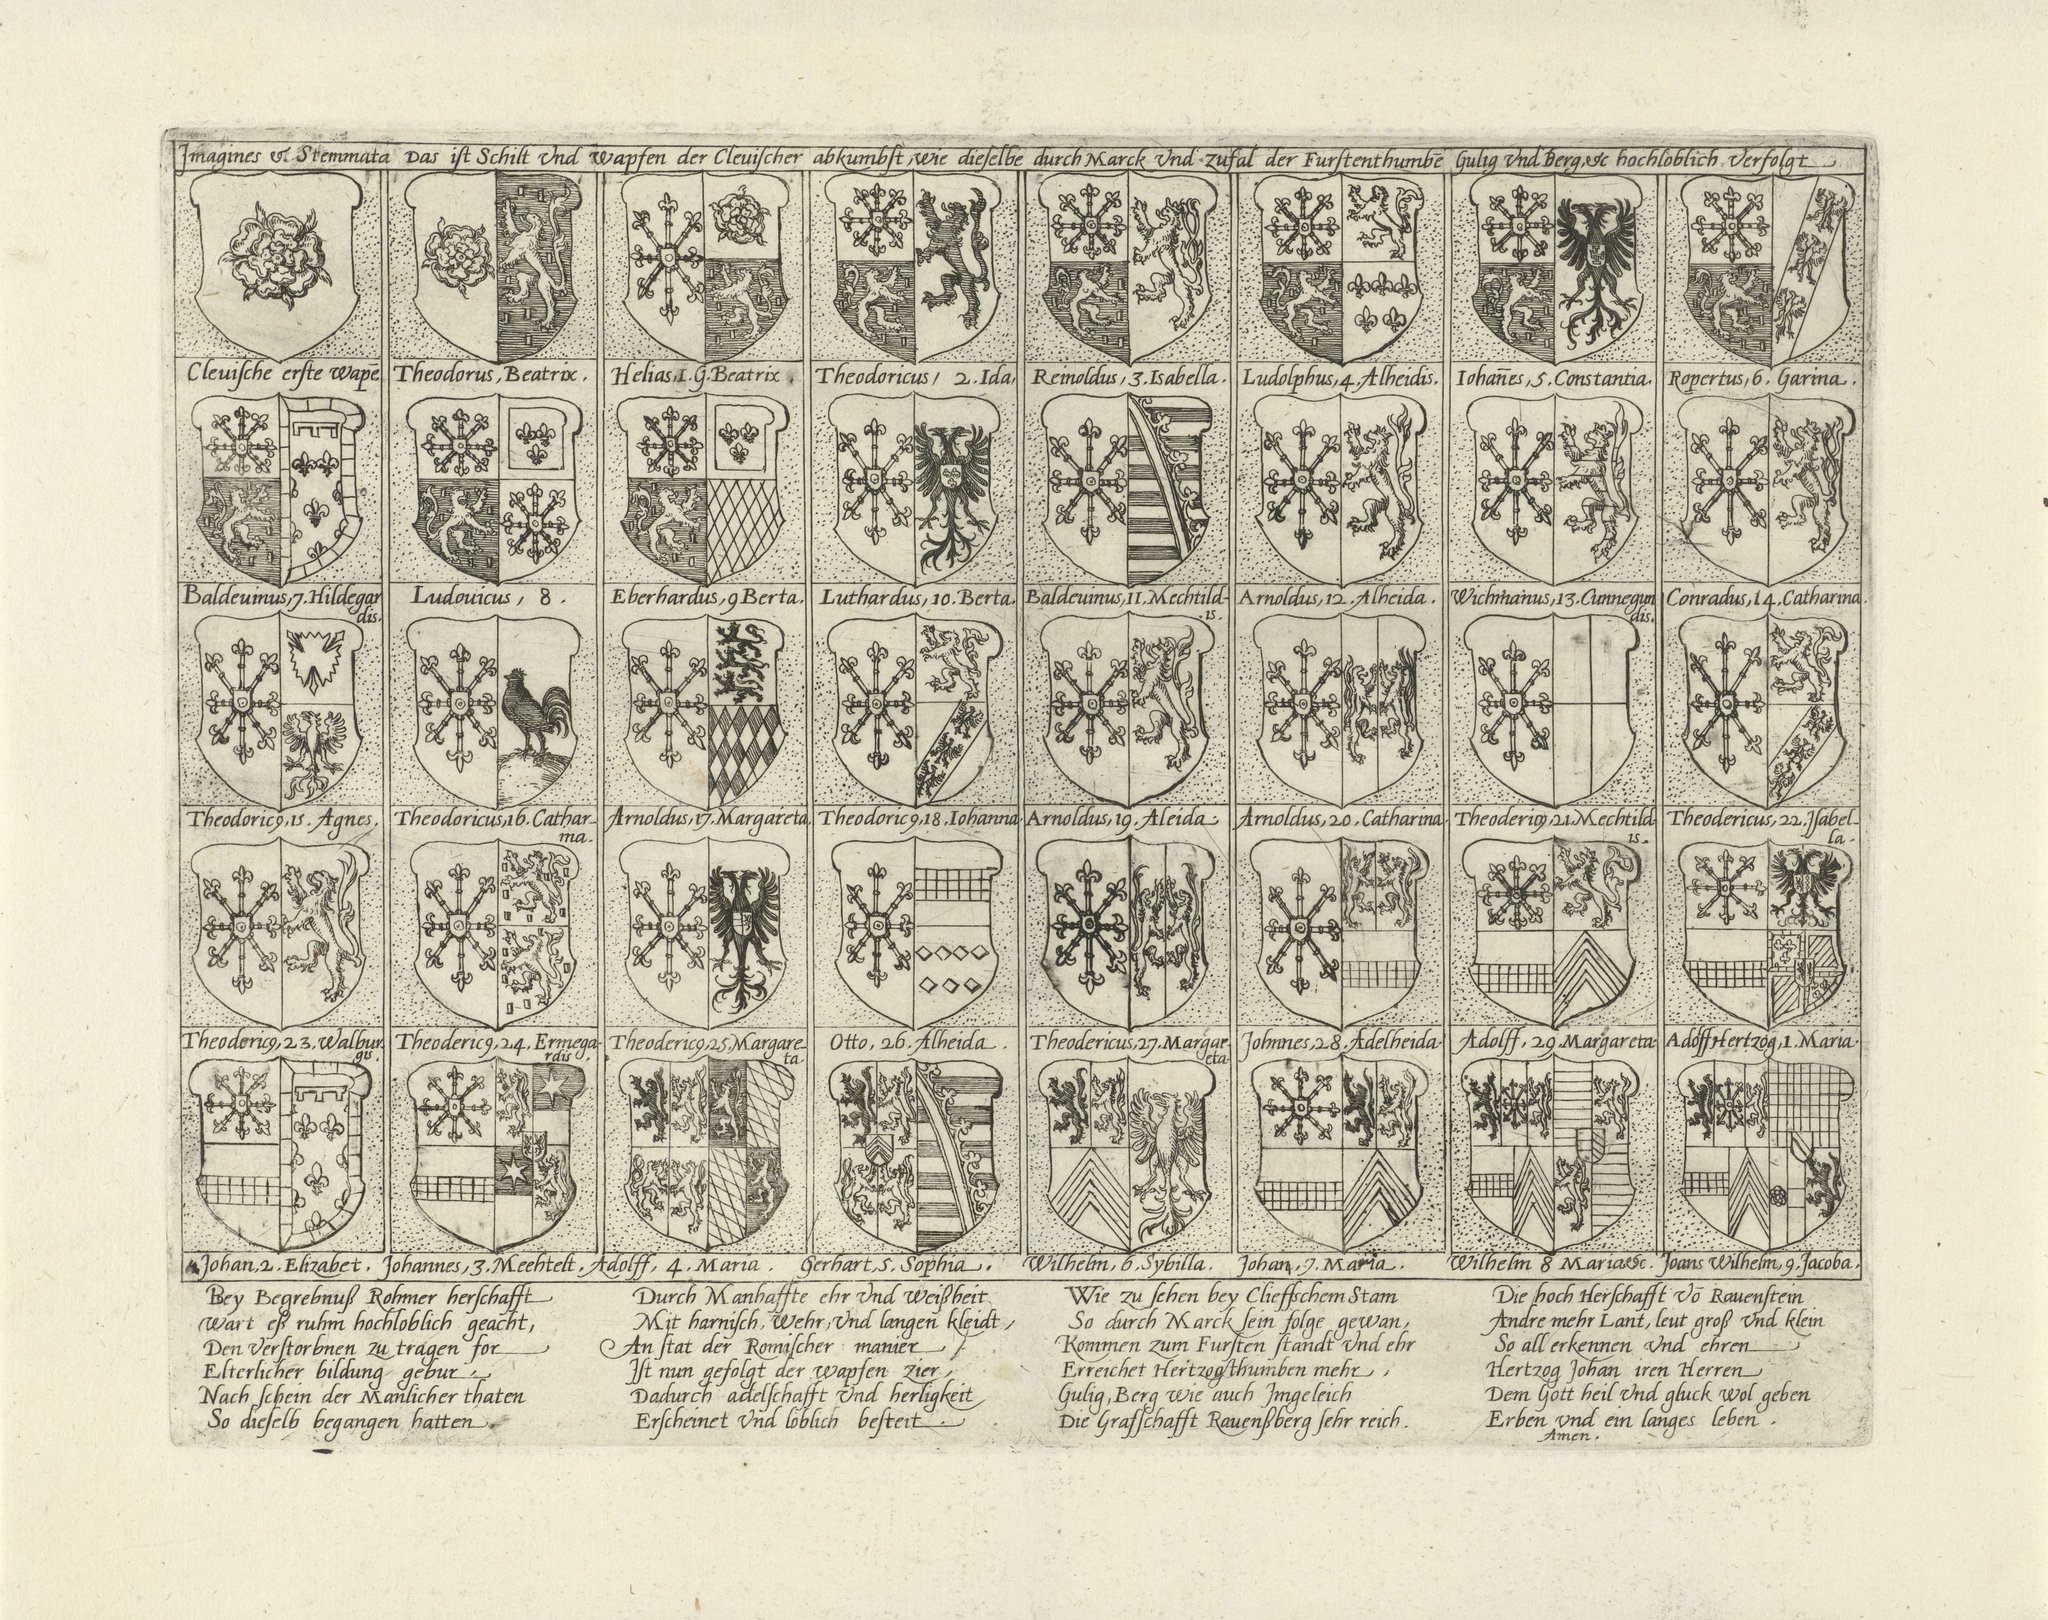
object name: print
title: Wapenschilden van Kleef, Mark en Gulik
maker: Anonymous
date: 1592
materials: paper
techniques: etching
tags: armorial bearing, heraldry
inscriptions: collector's mark: Lugt 2228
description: Prent ook gebruikt in: Graminaeus, Theodor. Spiegel vnd abbildung der Vergengligkeit: Darinnen was der Toden Recht vnd Geburnuß begriffen ... Vnd wie der Durchleuchtiger ... Herr Johan Wilhelm Hertzog zu Gülich, Cleue vnd Berg ... da jhr F.G. Herr Vatter Christmilter gedechtnuß, Hertzog Wilhelm ... im Jahr 1592. ... entschlaffen, ... am zehenden Tag Martij in der Collegiat Kirchen zu Düsseldorff ... begraben ... lassen. Keulen: Theodor Graminaeus, 1592.